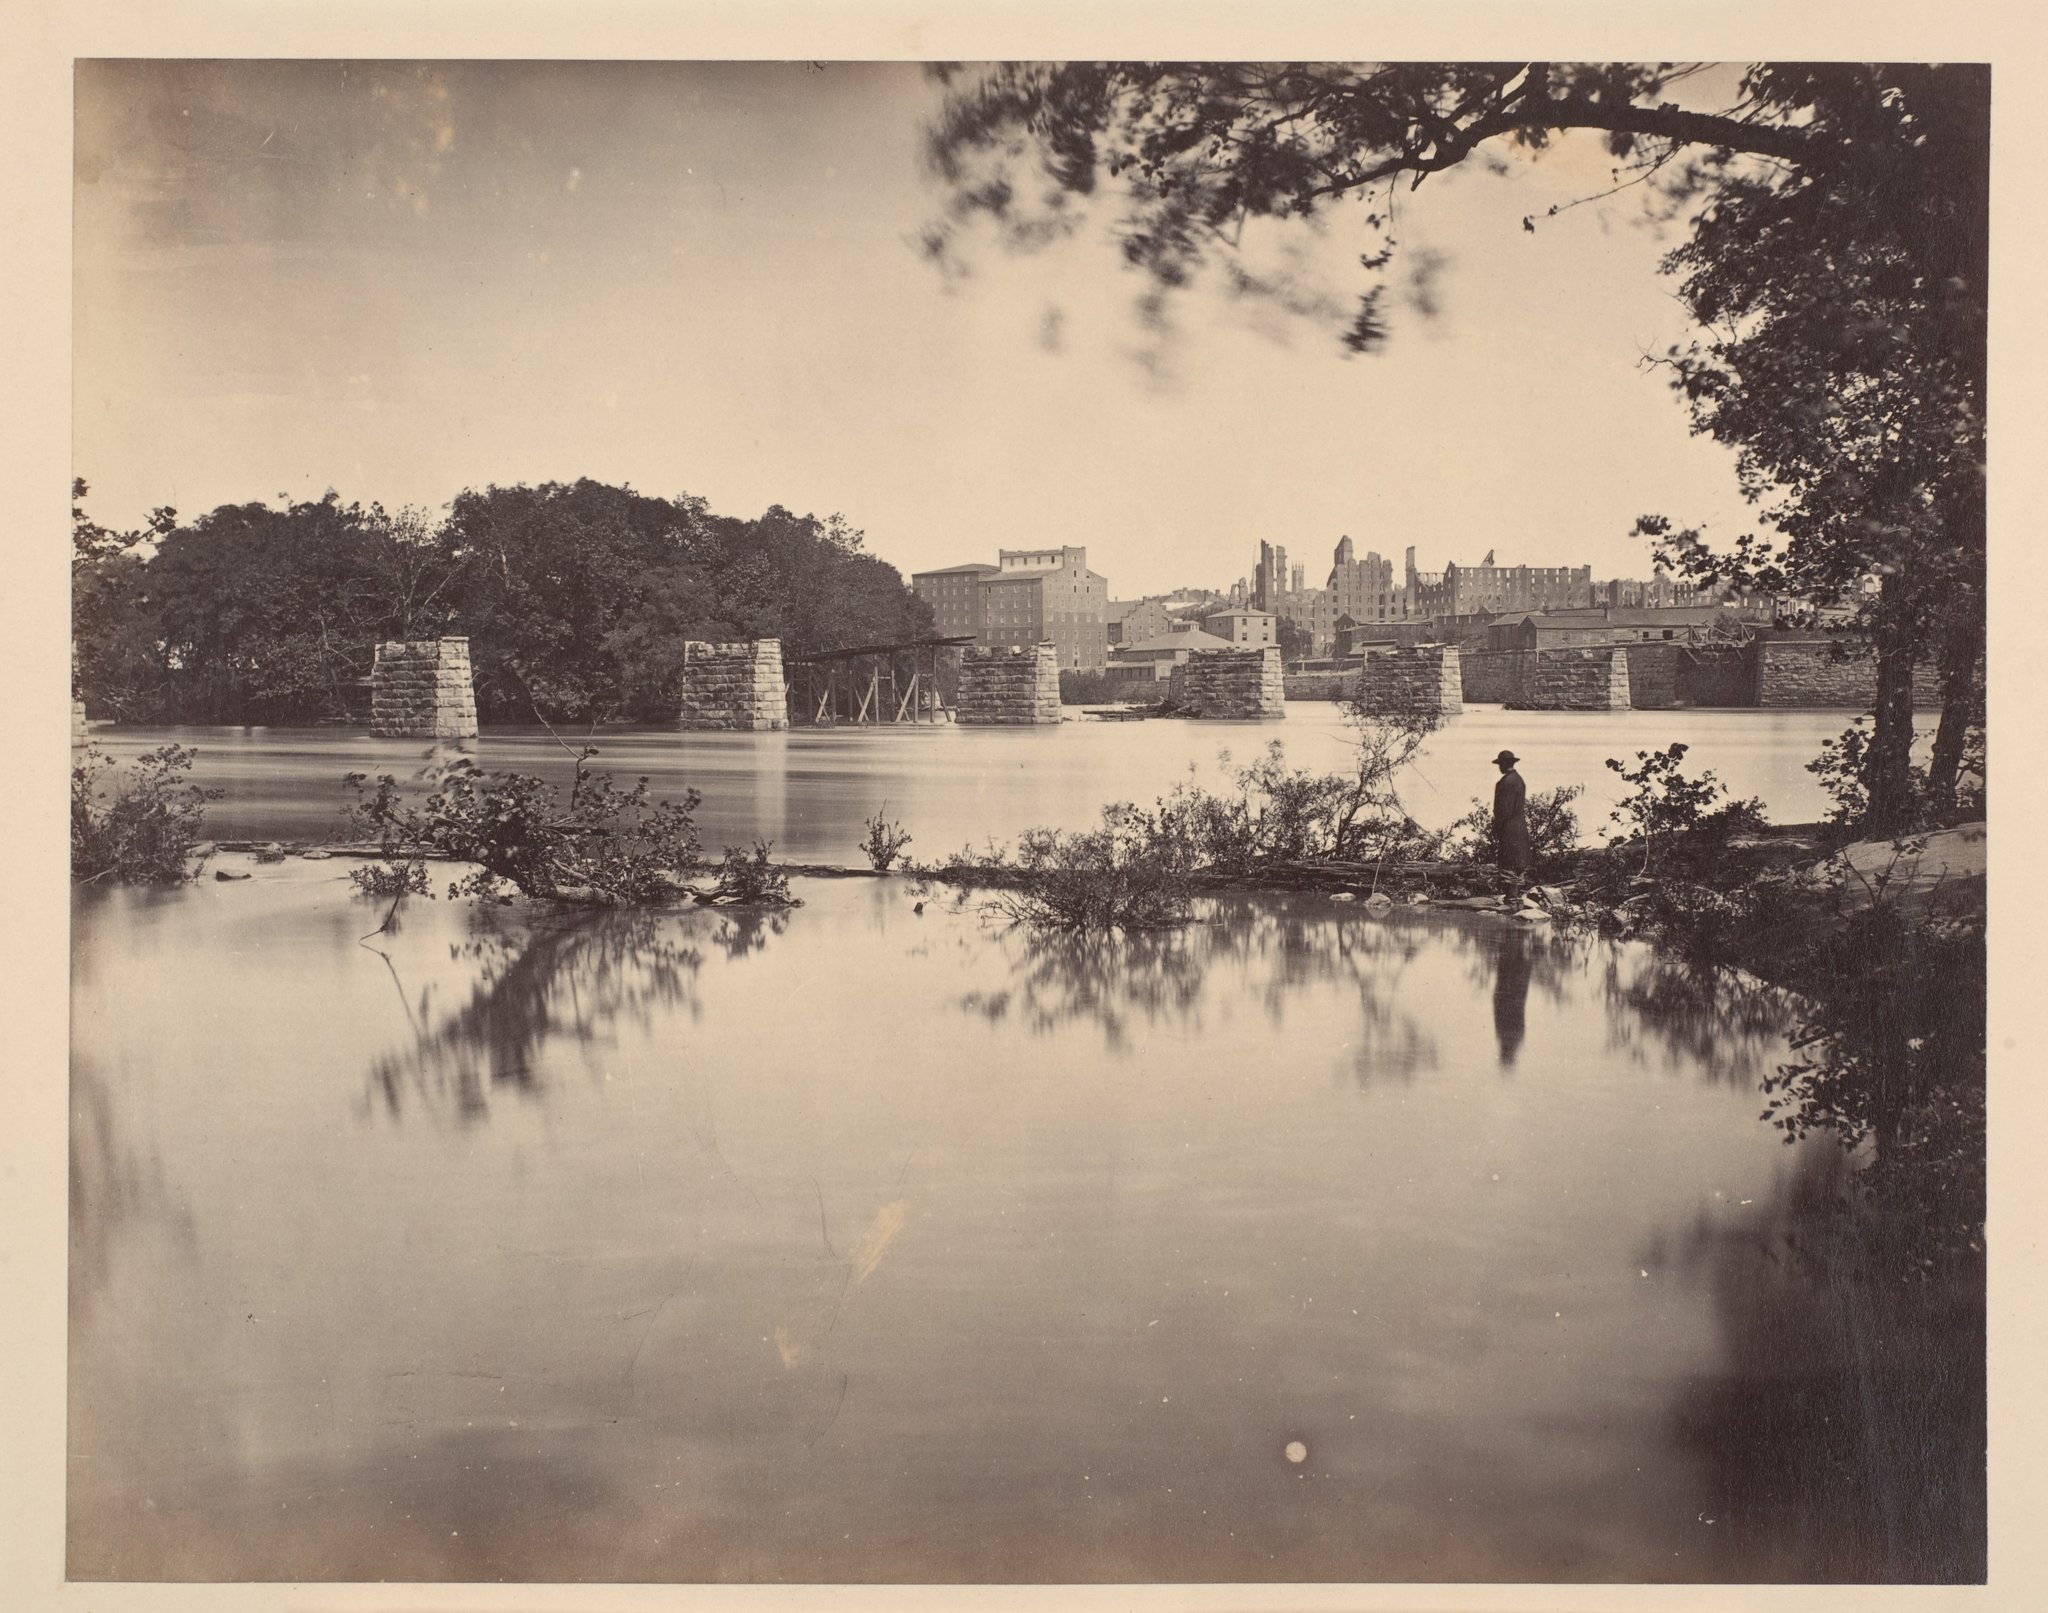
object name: photograph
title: [Civil War View]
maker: thomas c. roche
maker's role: artist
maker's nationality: american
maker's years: 1826-1895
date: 1860-1869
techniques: albumen silver print, glass negative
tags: american civil war,rivers